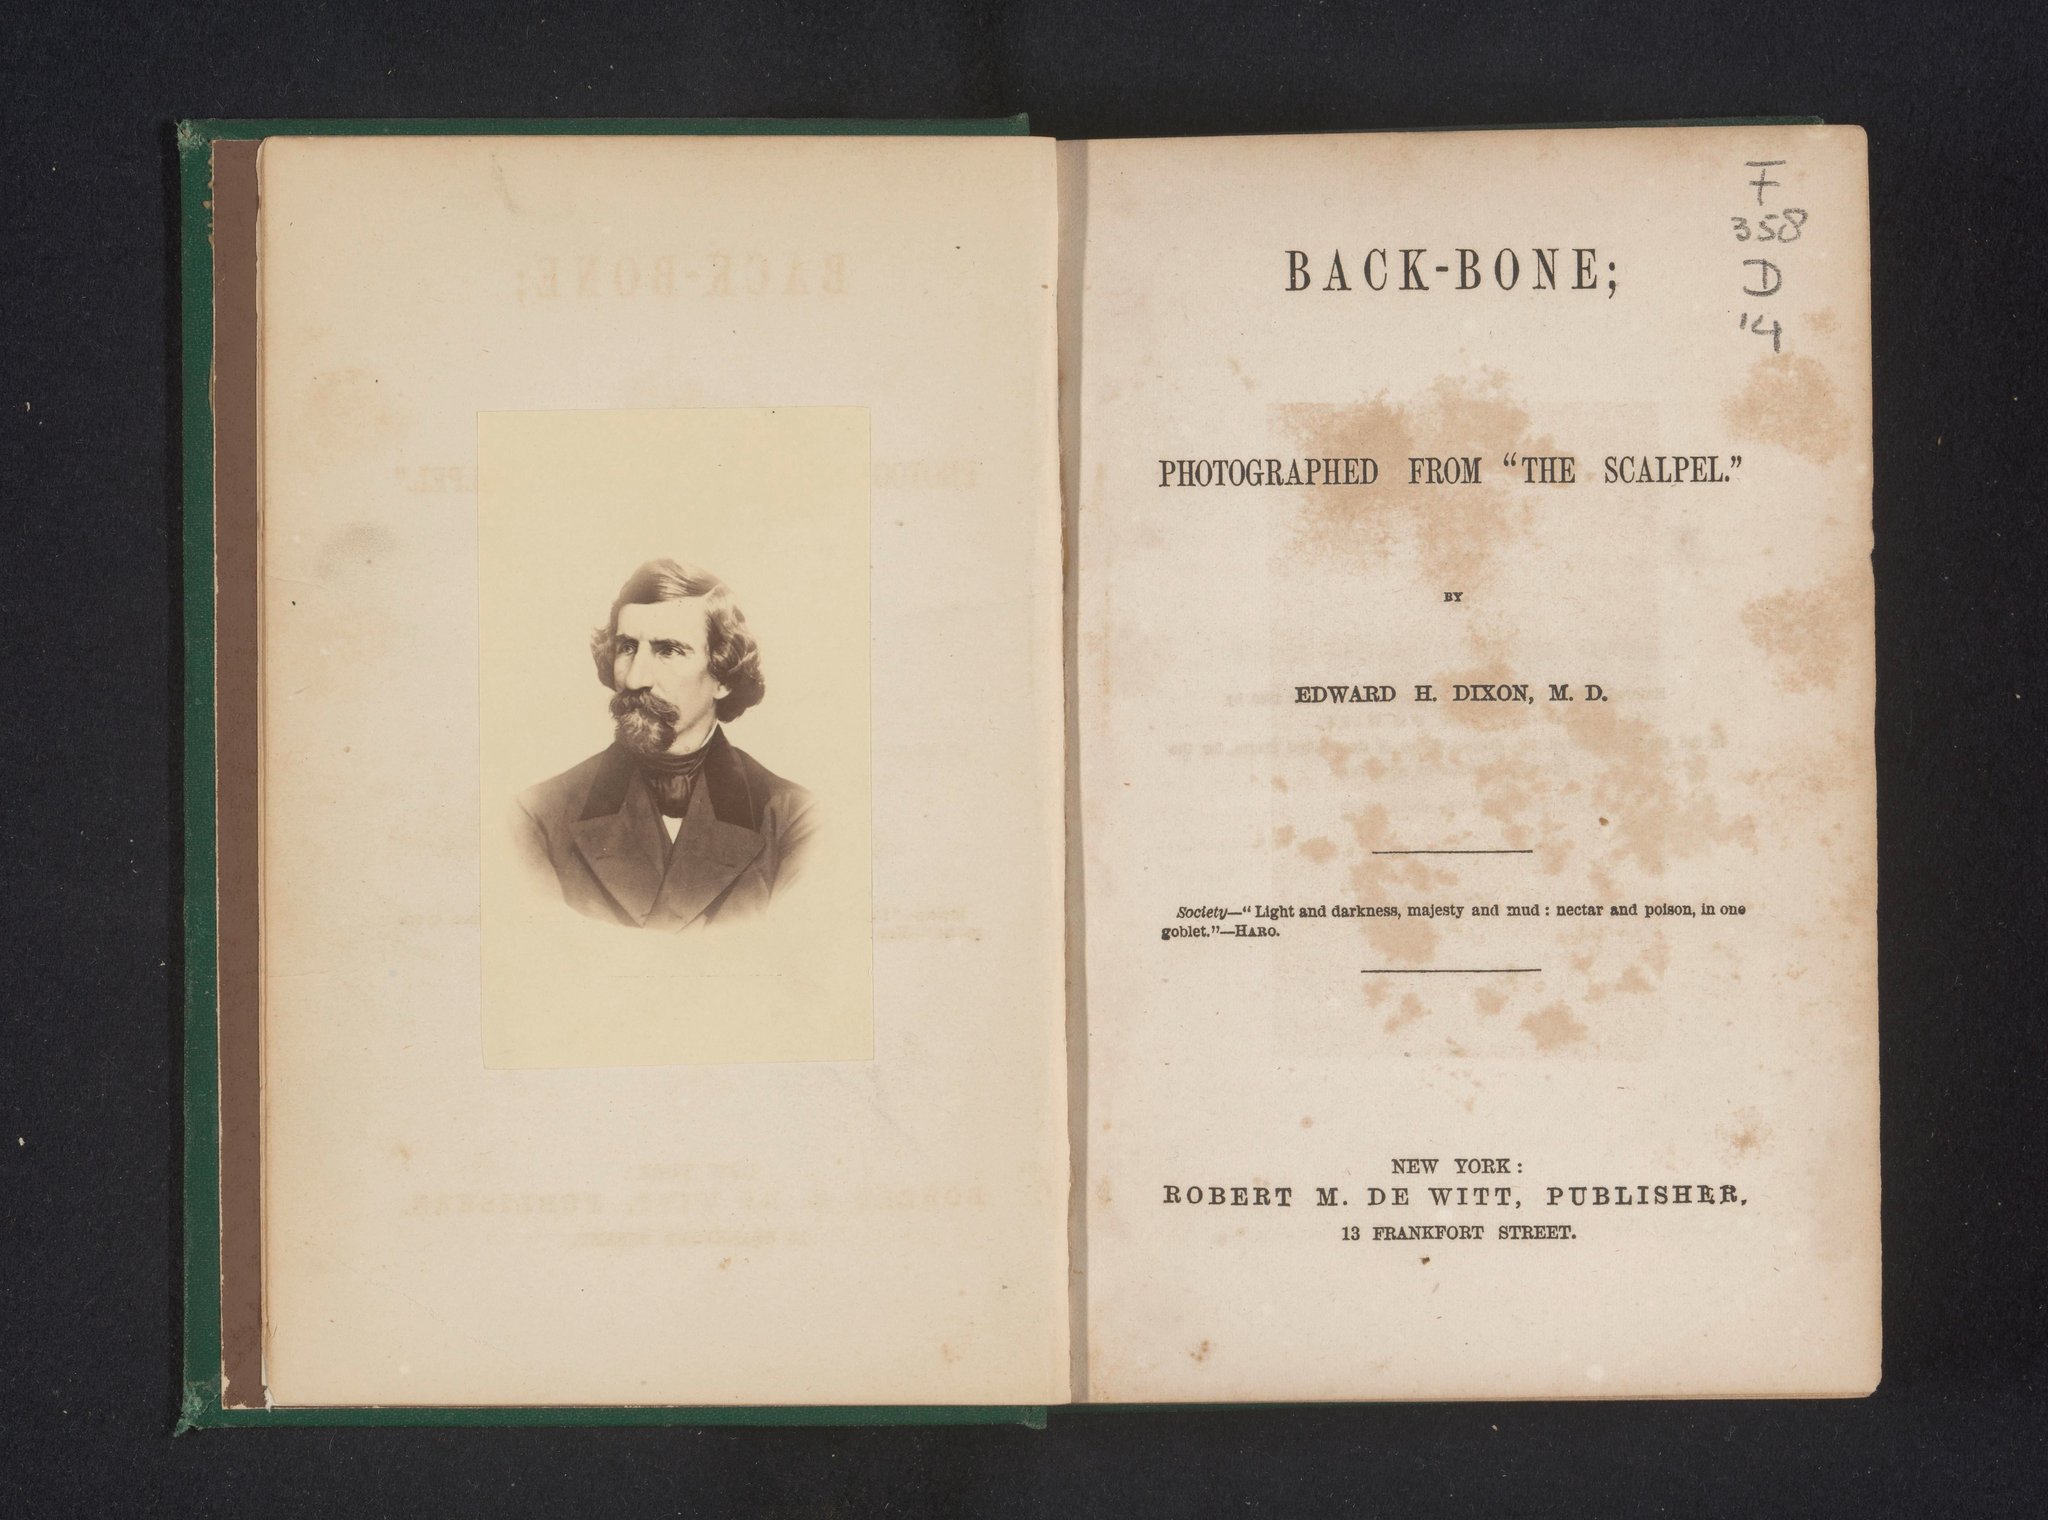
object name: book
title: Back-bone photographed from "the scalpel"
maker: edward h. dixon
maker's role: schrijver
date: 1866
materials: cardboard, linen, paper, photographic support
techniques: albumen print, printing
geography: new york city